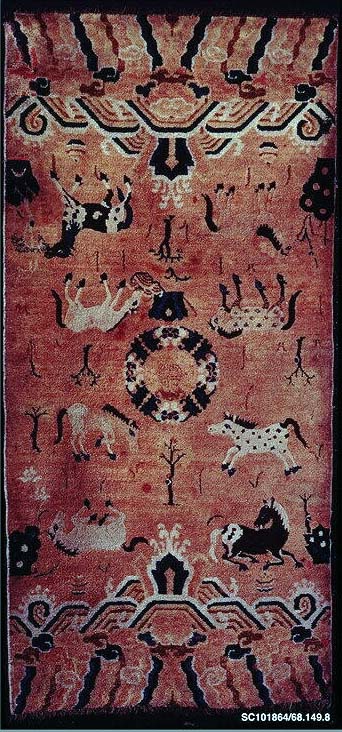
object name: rug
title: Saddle or Traveler's Rug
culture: chinese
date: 1801-1900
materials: cotton, wool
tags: horses